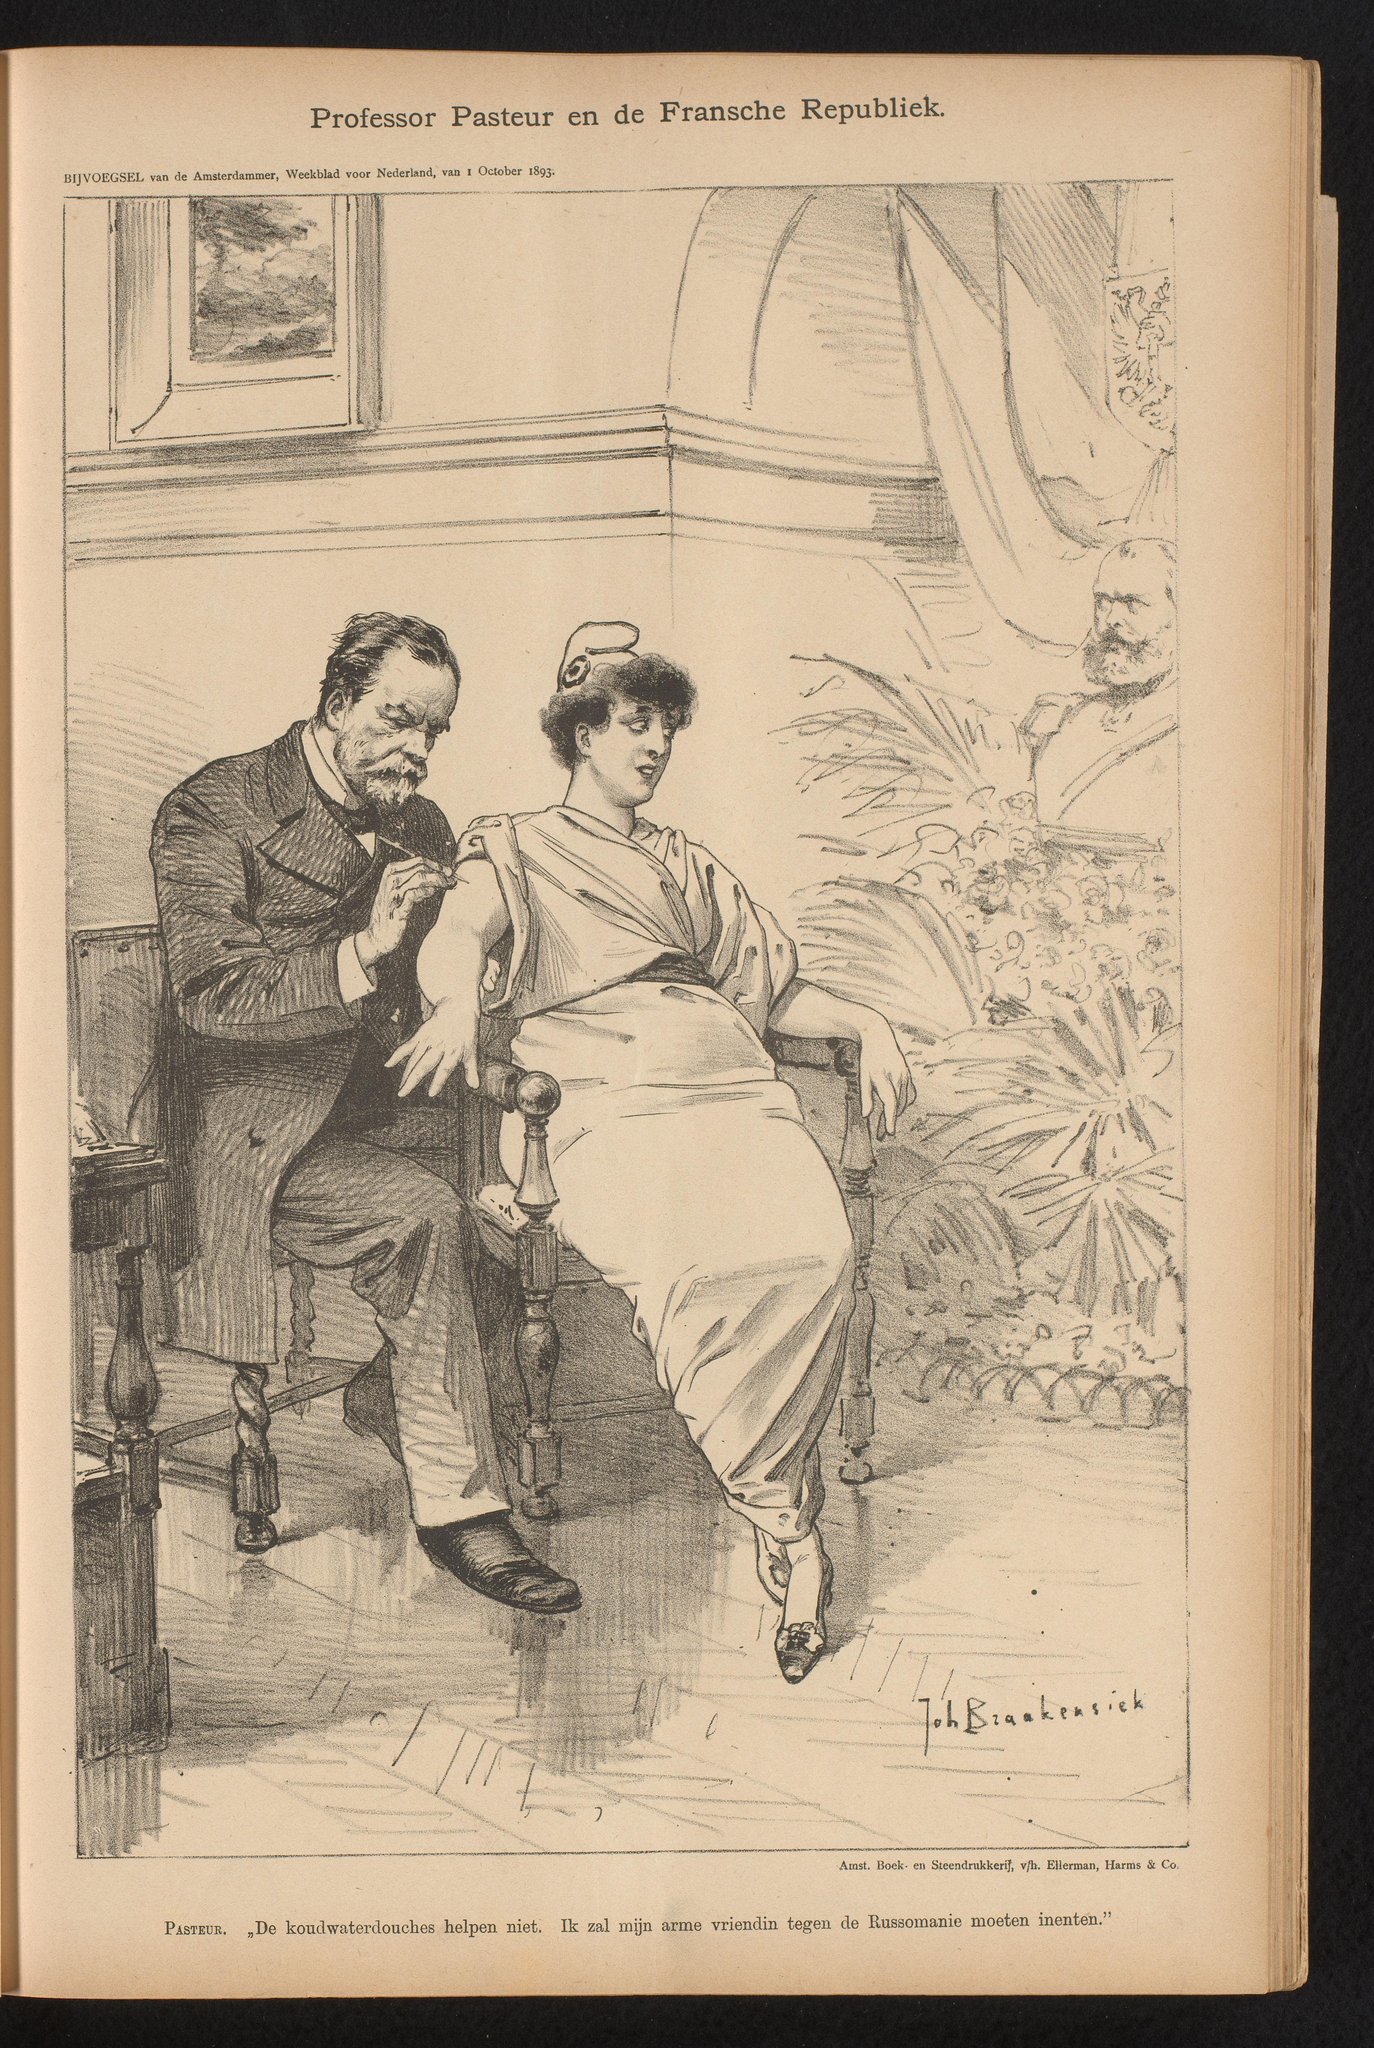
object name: cartoon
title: Professor Pasteur en de Fransche Republiek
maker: johan braakensiek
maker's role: draughtsman, print maker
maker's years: 1858-1940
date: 1893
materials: paper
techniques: lithograph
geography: amsterdam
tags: personifications of countries, nations, states, districts, etc., vaccination, political caricatures and satires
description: Marianne (Frankrijk) wordt door Louis Pasteur ingeënt met het vaccin tegen de 'Russomanie'. Rechts een buste van de Russische tsaar Alexander III.